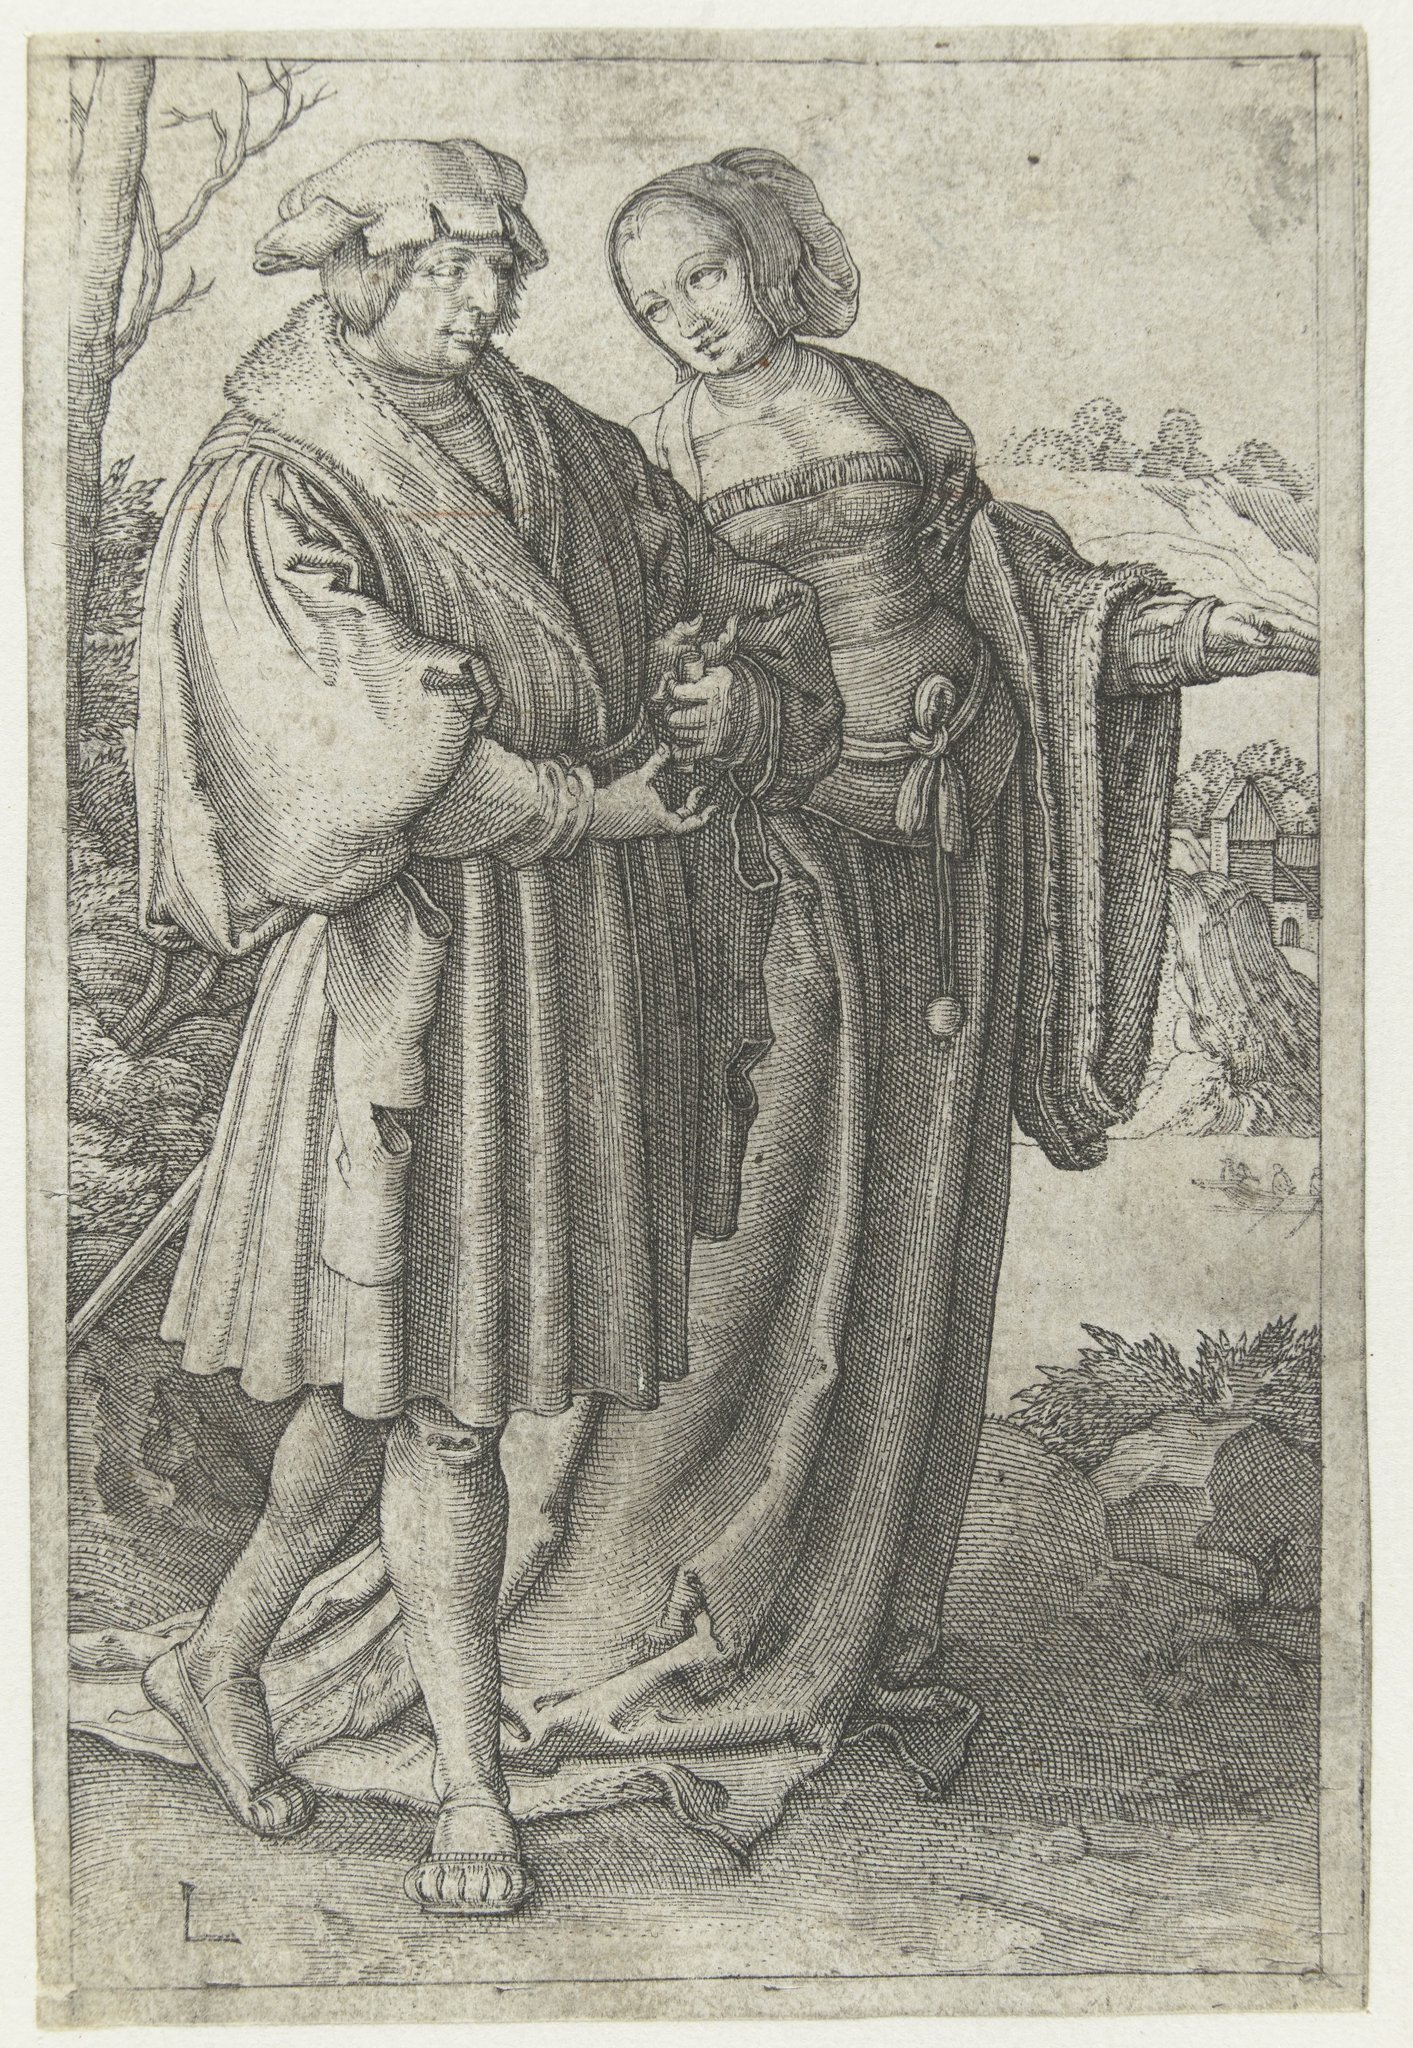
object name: print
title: Wandelend paar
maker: lucas van leyden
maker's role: draughtsman, painter, print maker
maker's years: 1494-1533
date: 1581-1628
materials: paper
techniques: engraving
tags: pacing, striding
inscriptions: collector's mark: Lugt 557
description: Wandelend paar, gekleed volgens de burgerlijke mode van ca. 1520